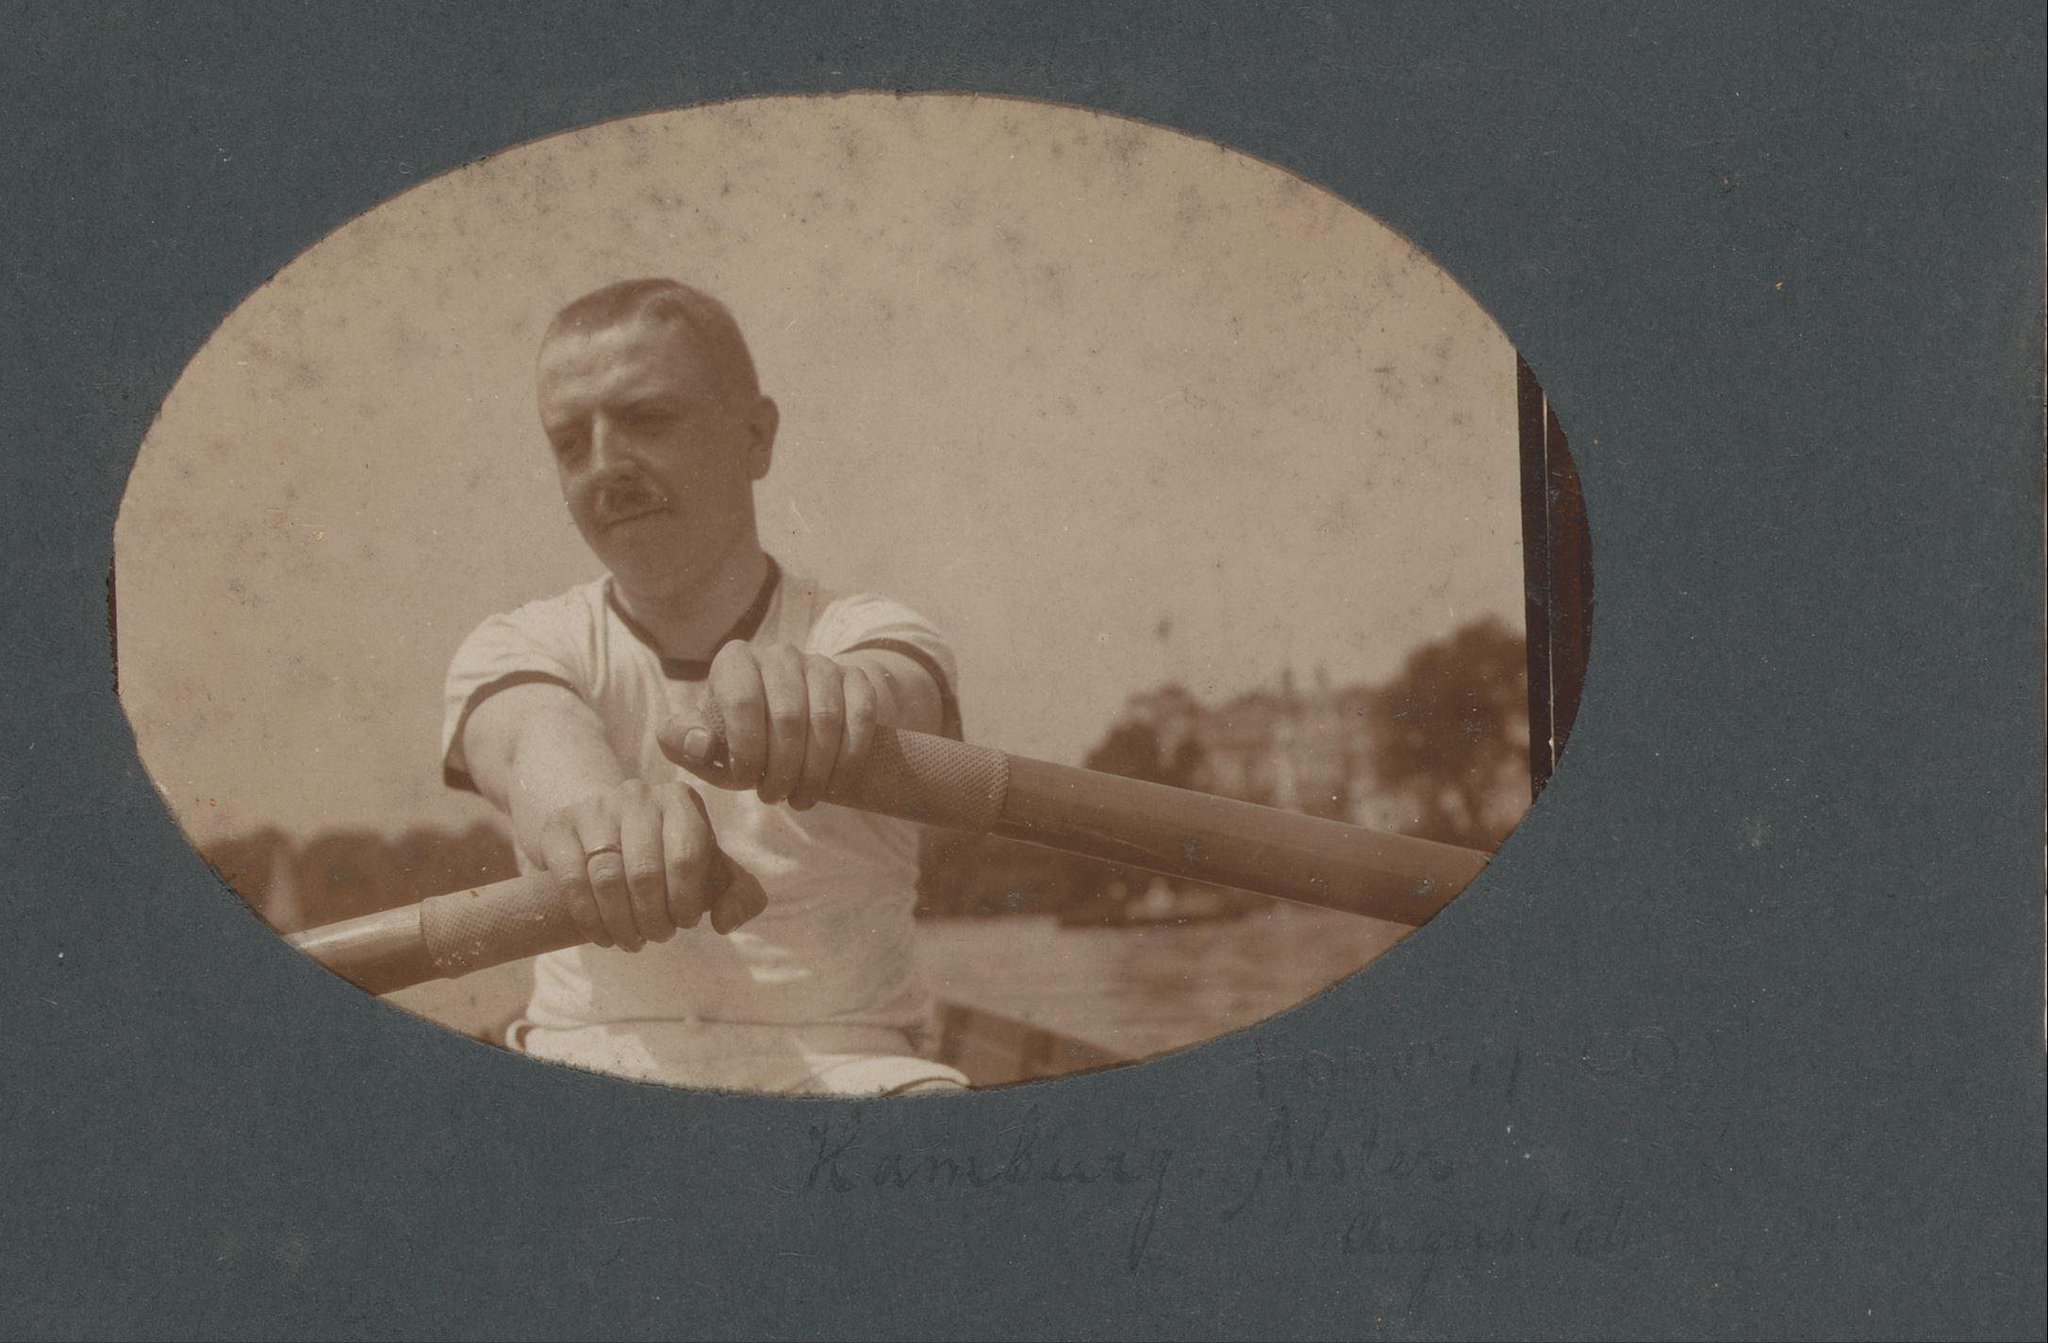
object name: photograph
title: Roeier op de Alster te Hamburg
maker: Anonymous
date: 1906-1908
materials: cardboard, paper, photographic support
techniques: collodion silver print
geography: hamburg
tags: rowing, canoeing, etc. (sport) (+ sportsman, player, etc.)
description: Onderdeel van Reisalbum van een Nederlandse familie met bezienswaardigheden in Europa, Egypte en New York.